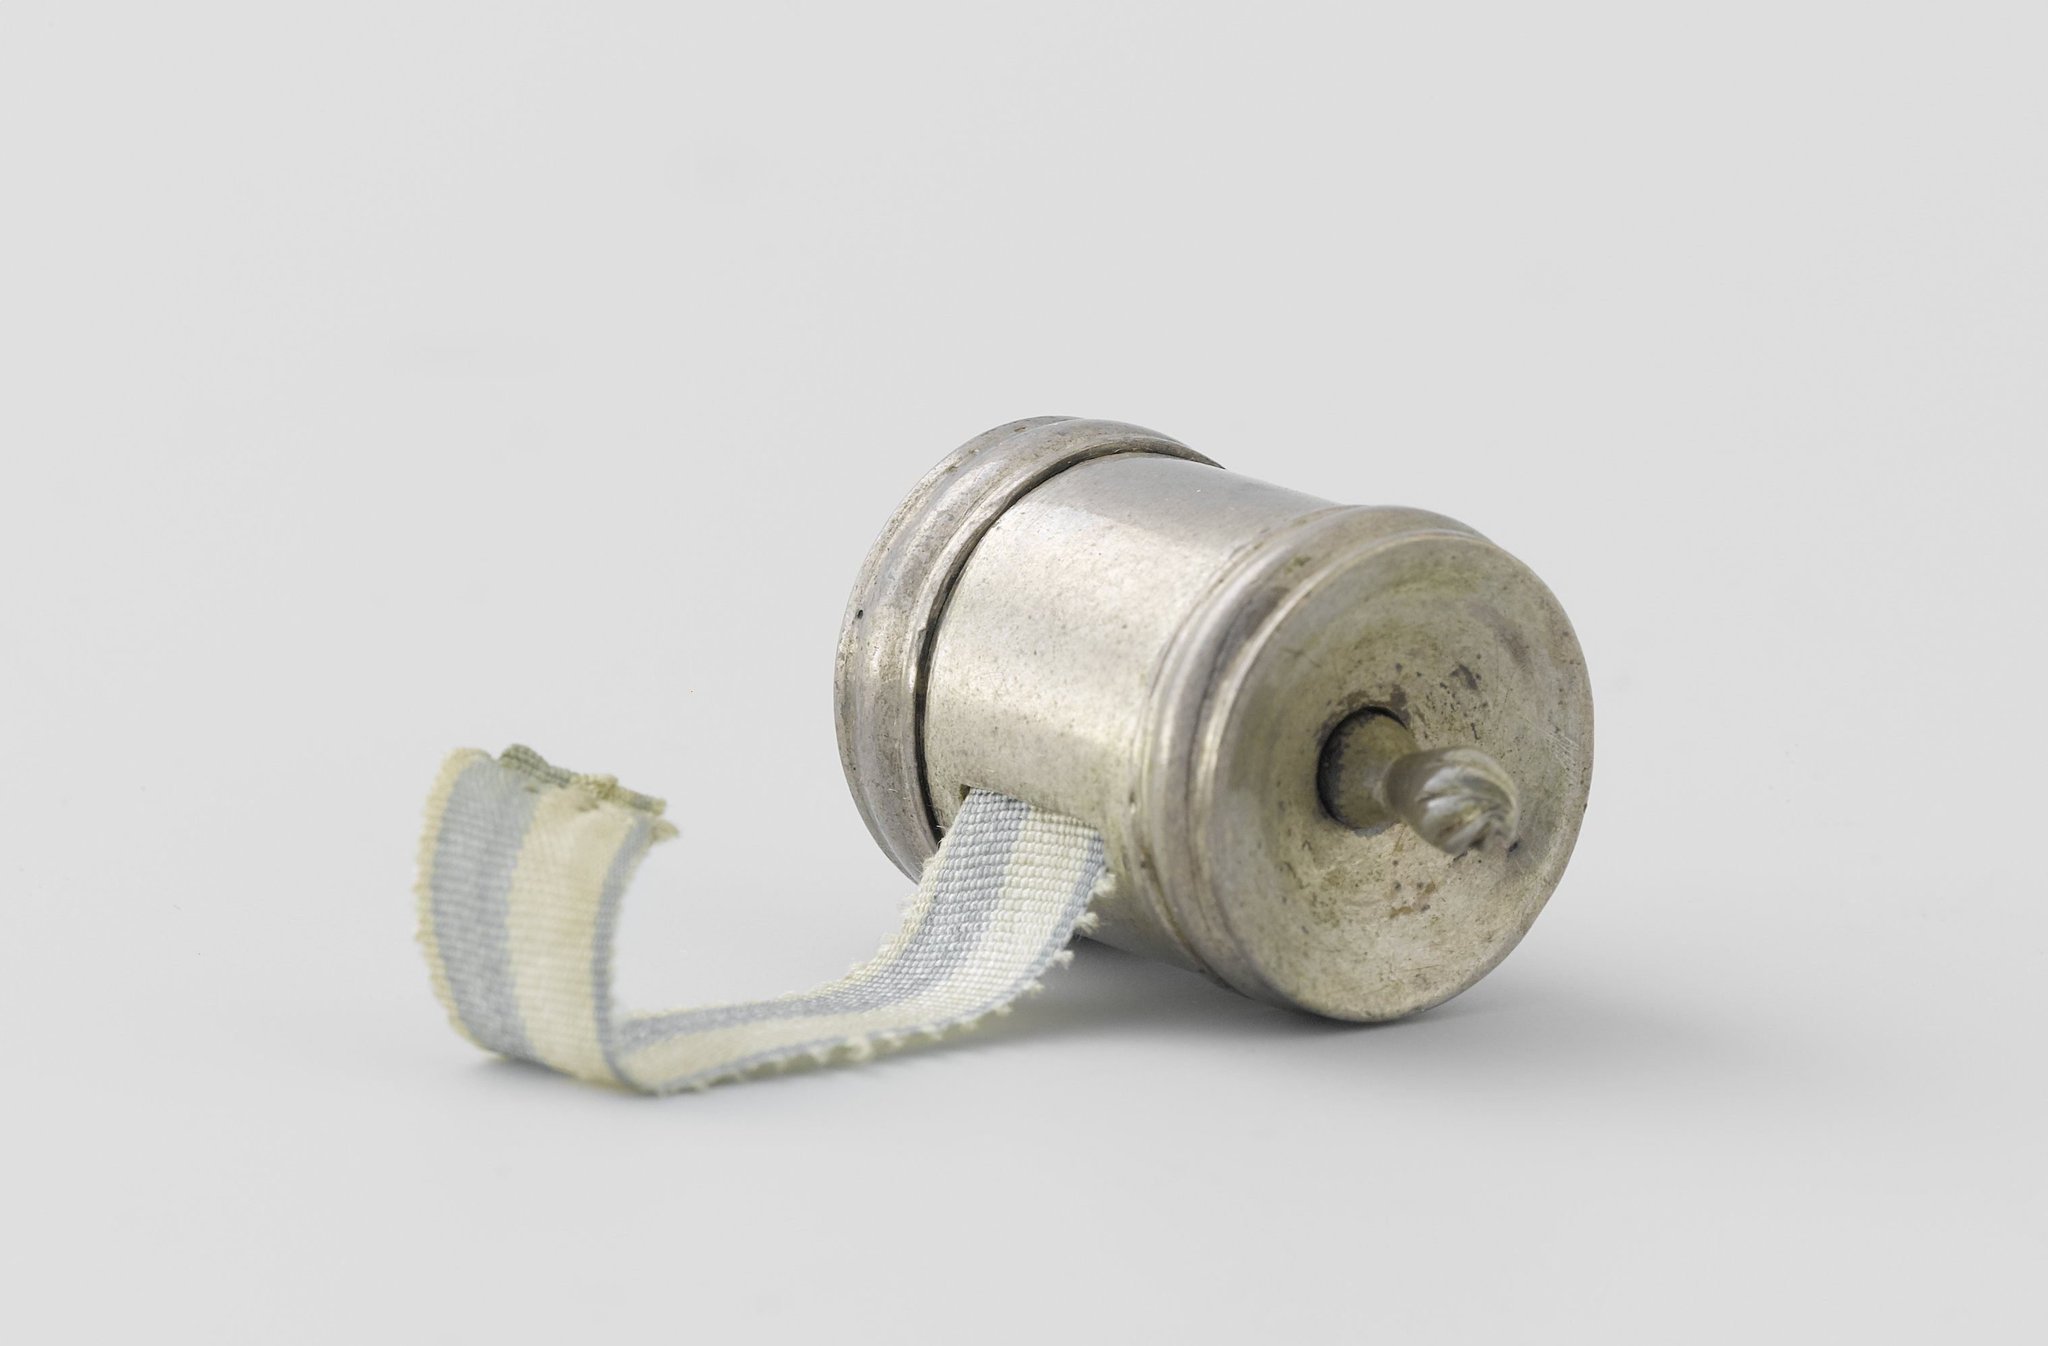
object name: miniature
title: Koker voor een meetlint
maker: Anonymous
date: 1700-1800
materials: silk, silver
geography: netherlands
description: Koker met daarin een maatlint. De randen van de koker zijn geprofileerd. Op het deksel is een knop waarmee het maatlint opgerold kan worden. Het maatlint is gemaakt van blauwe en witte zijde. De koker is niet gemerkt.